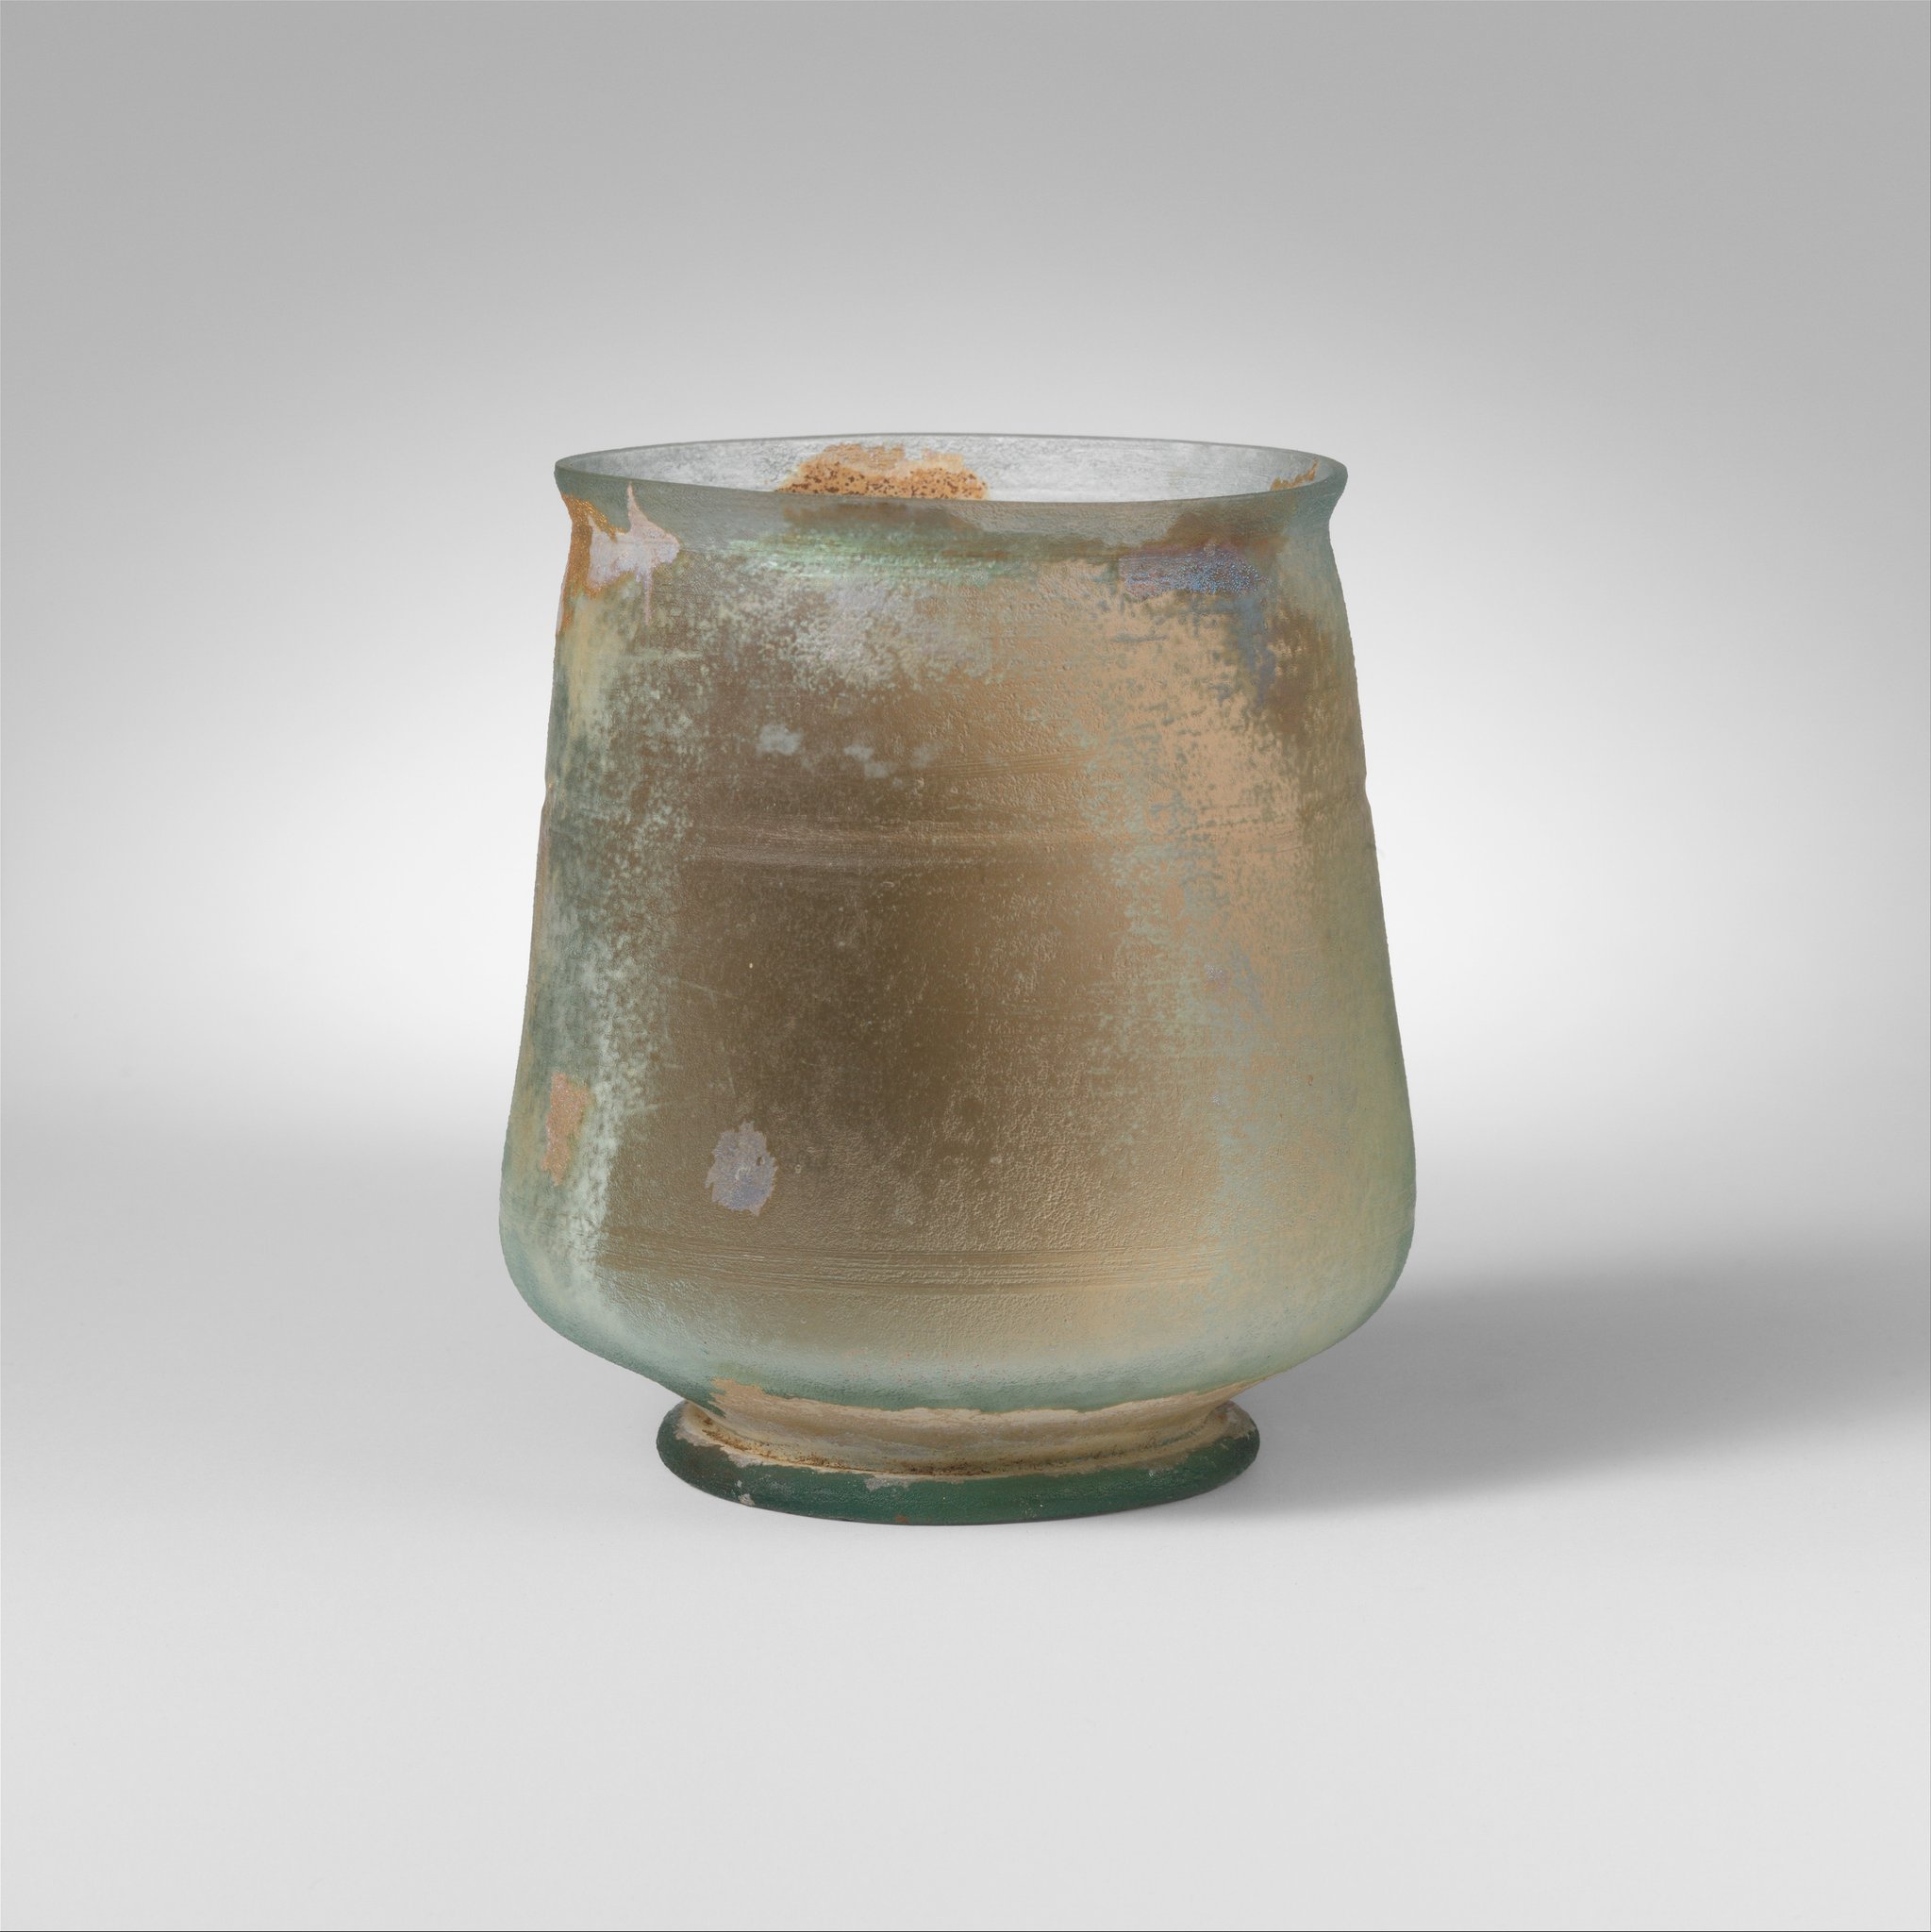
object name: beaker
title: Glass footed beaker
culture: roman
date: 67-166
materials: glass